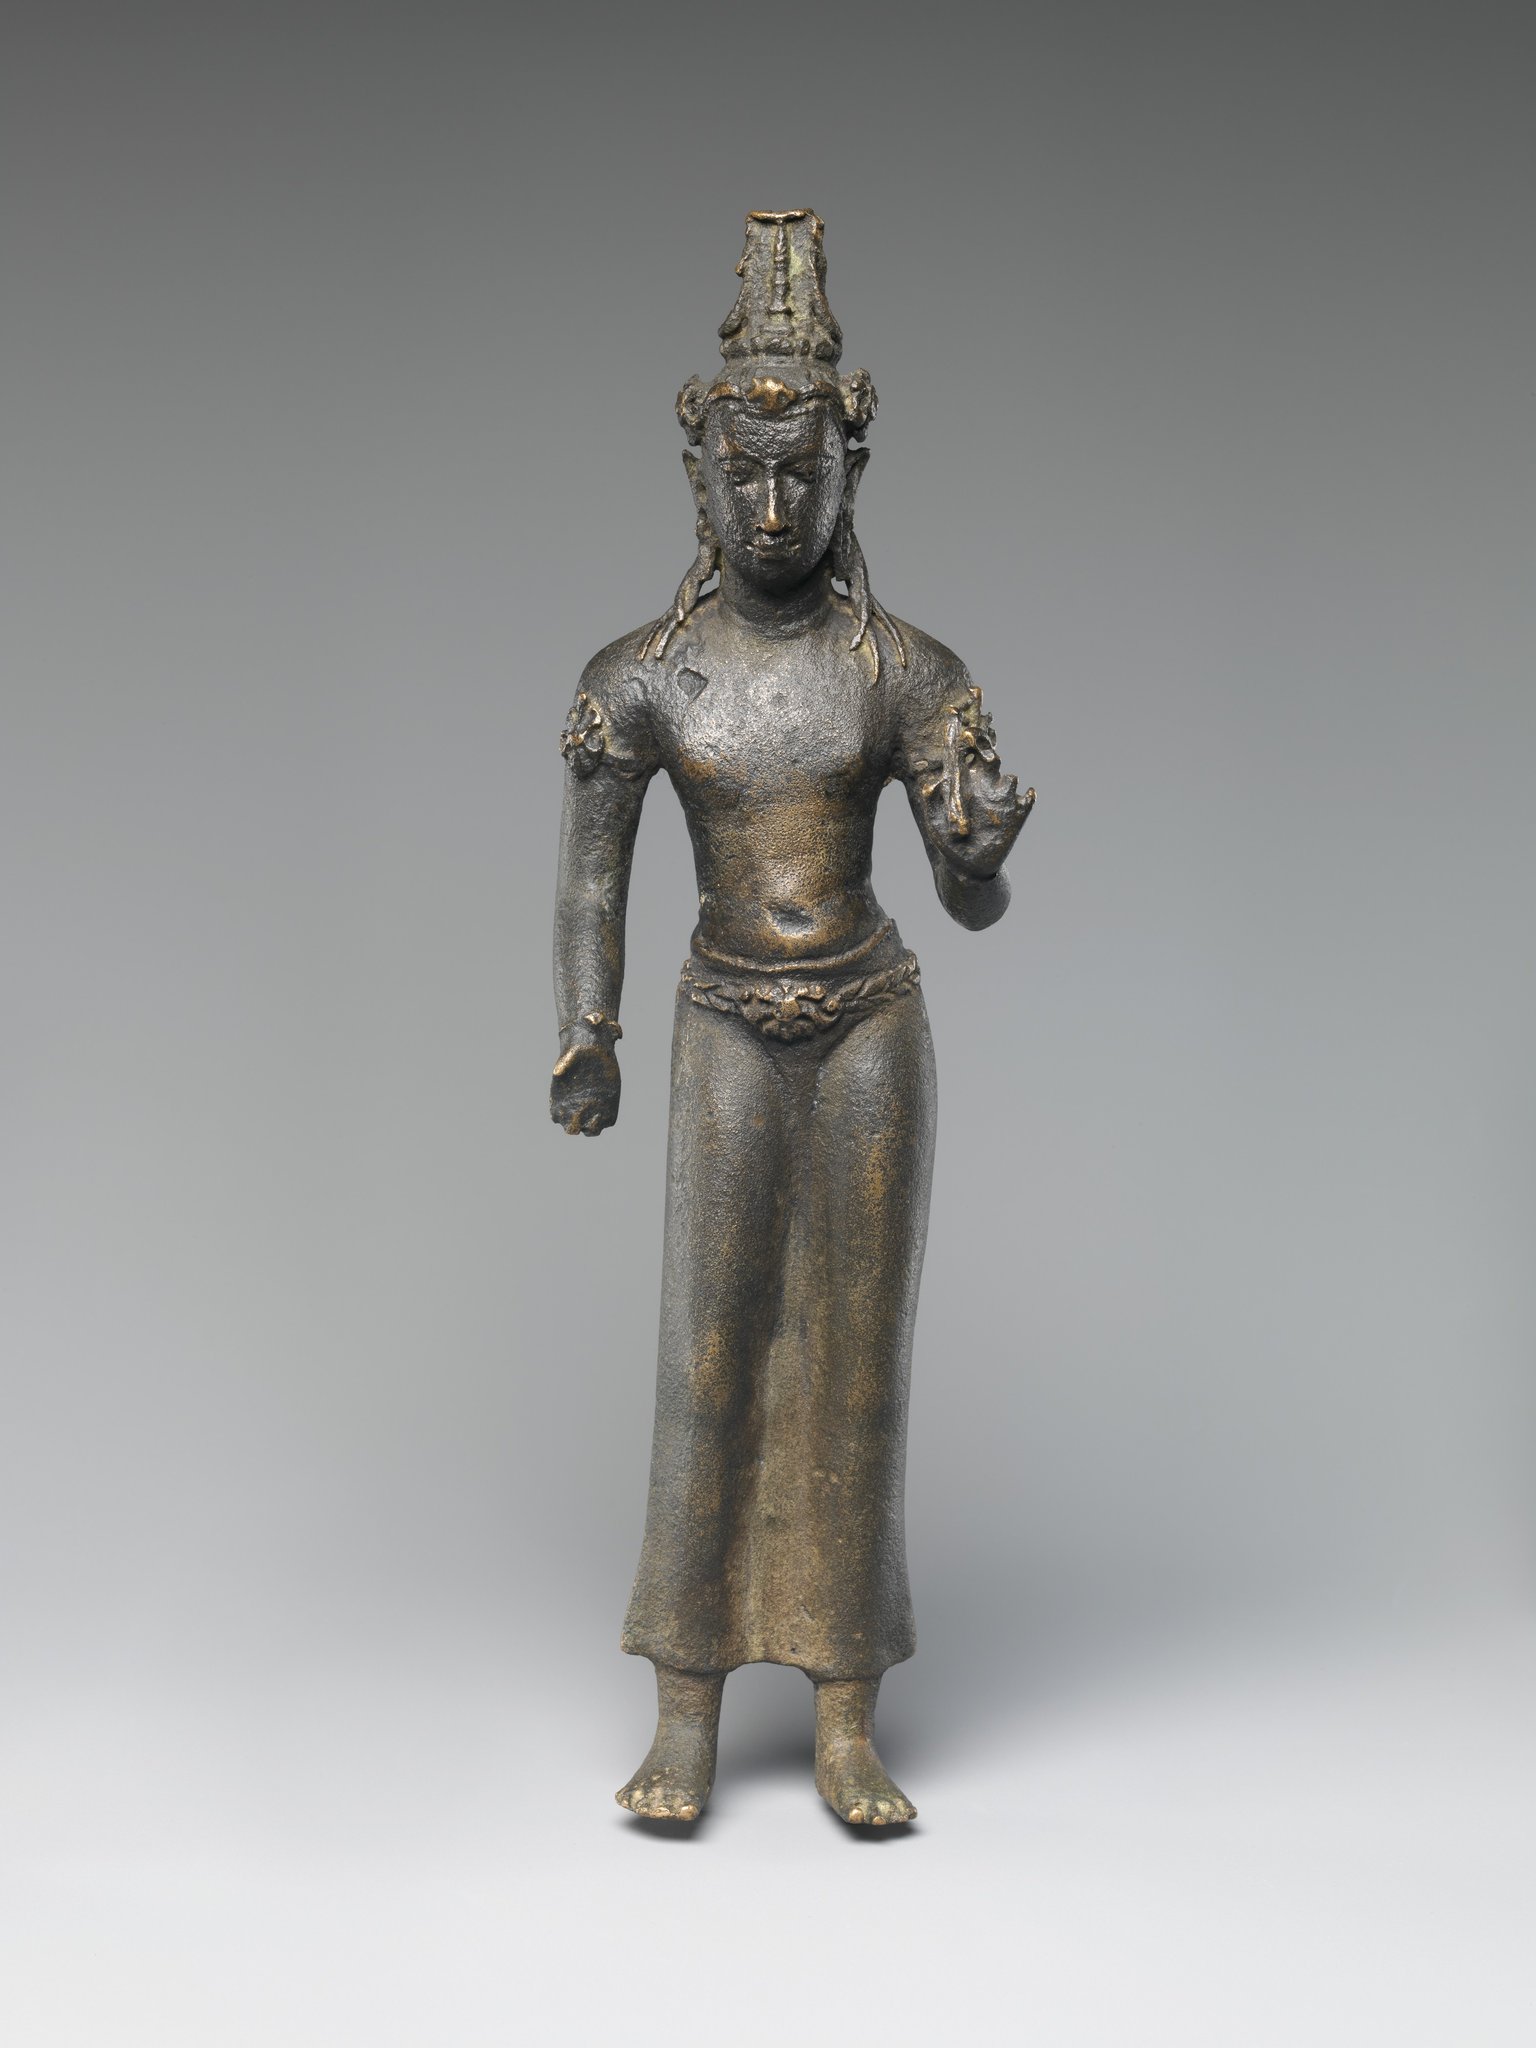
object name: figure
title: Standing Bodhisattva Maitreya or Manjushri(?)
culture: indonesian, sumatran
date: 667-833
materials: bronze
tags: buddhism,bodhisattvas